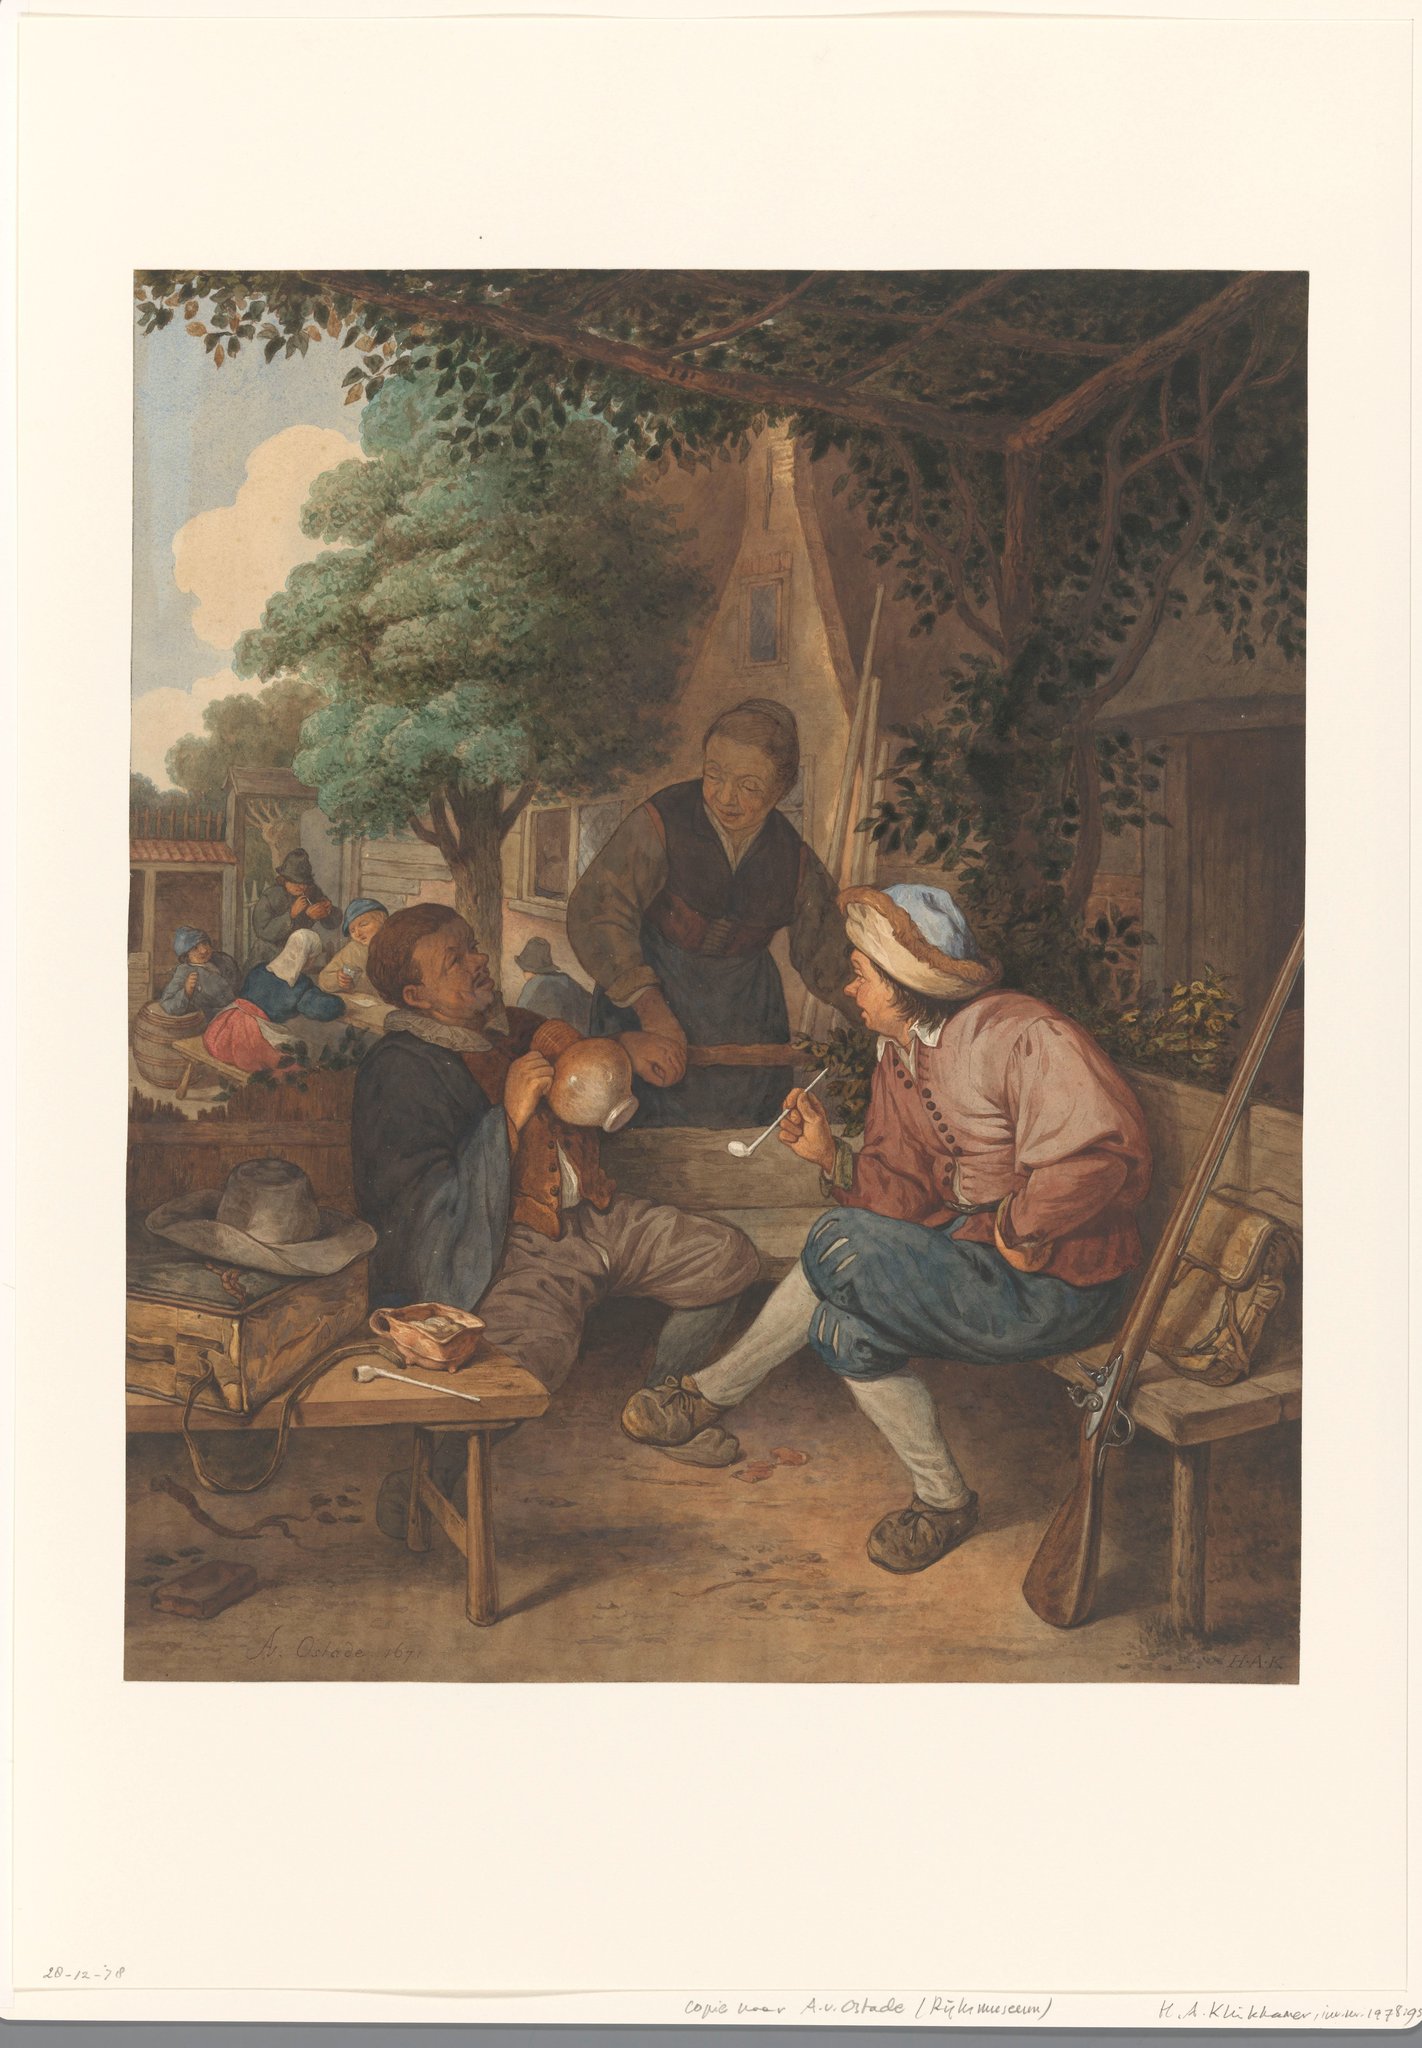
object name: watercolor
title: Rustende reizigers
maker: hendrik abraham klinkhamer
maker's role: draughtsman, painter, print maker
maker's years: 1810-1872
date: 1869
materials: paper, pencil, watercolor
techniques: brush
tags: (traveller) resting in the open air, pavement, terrace in front of inn or restaurant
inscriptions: date: ‘1869’